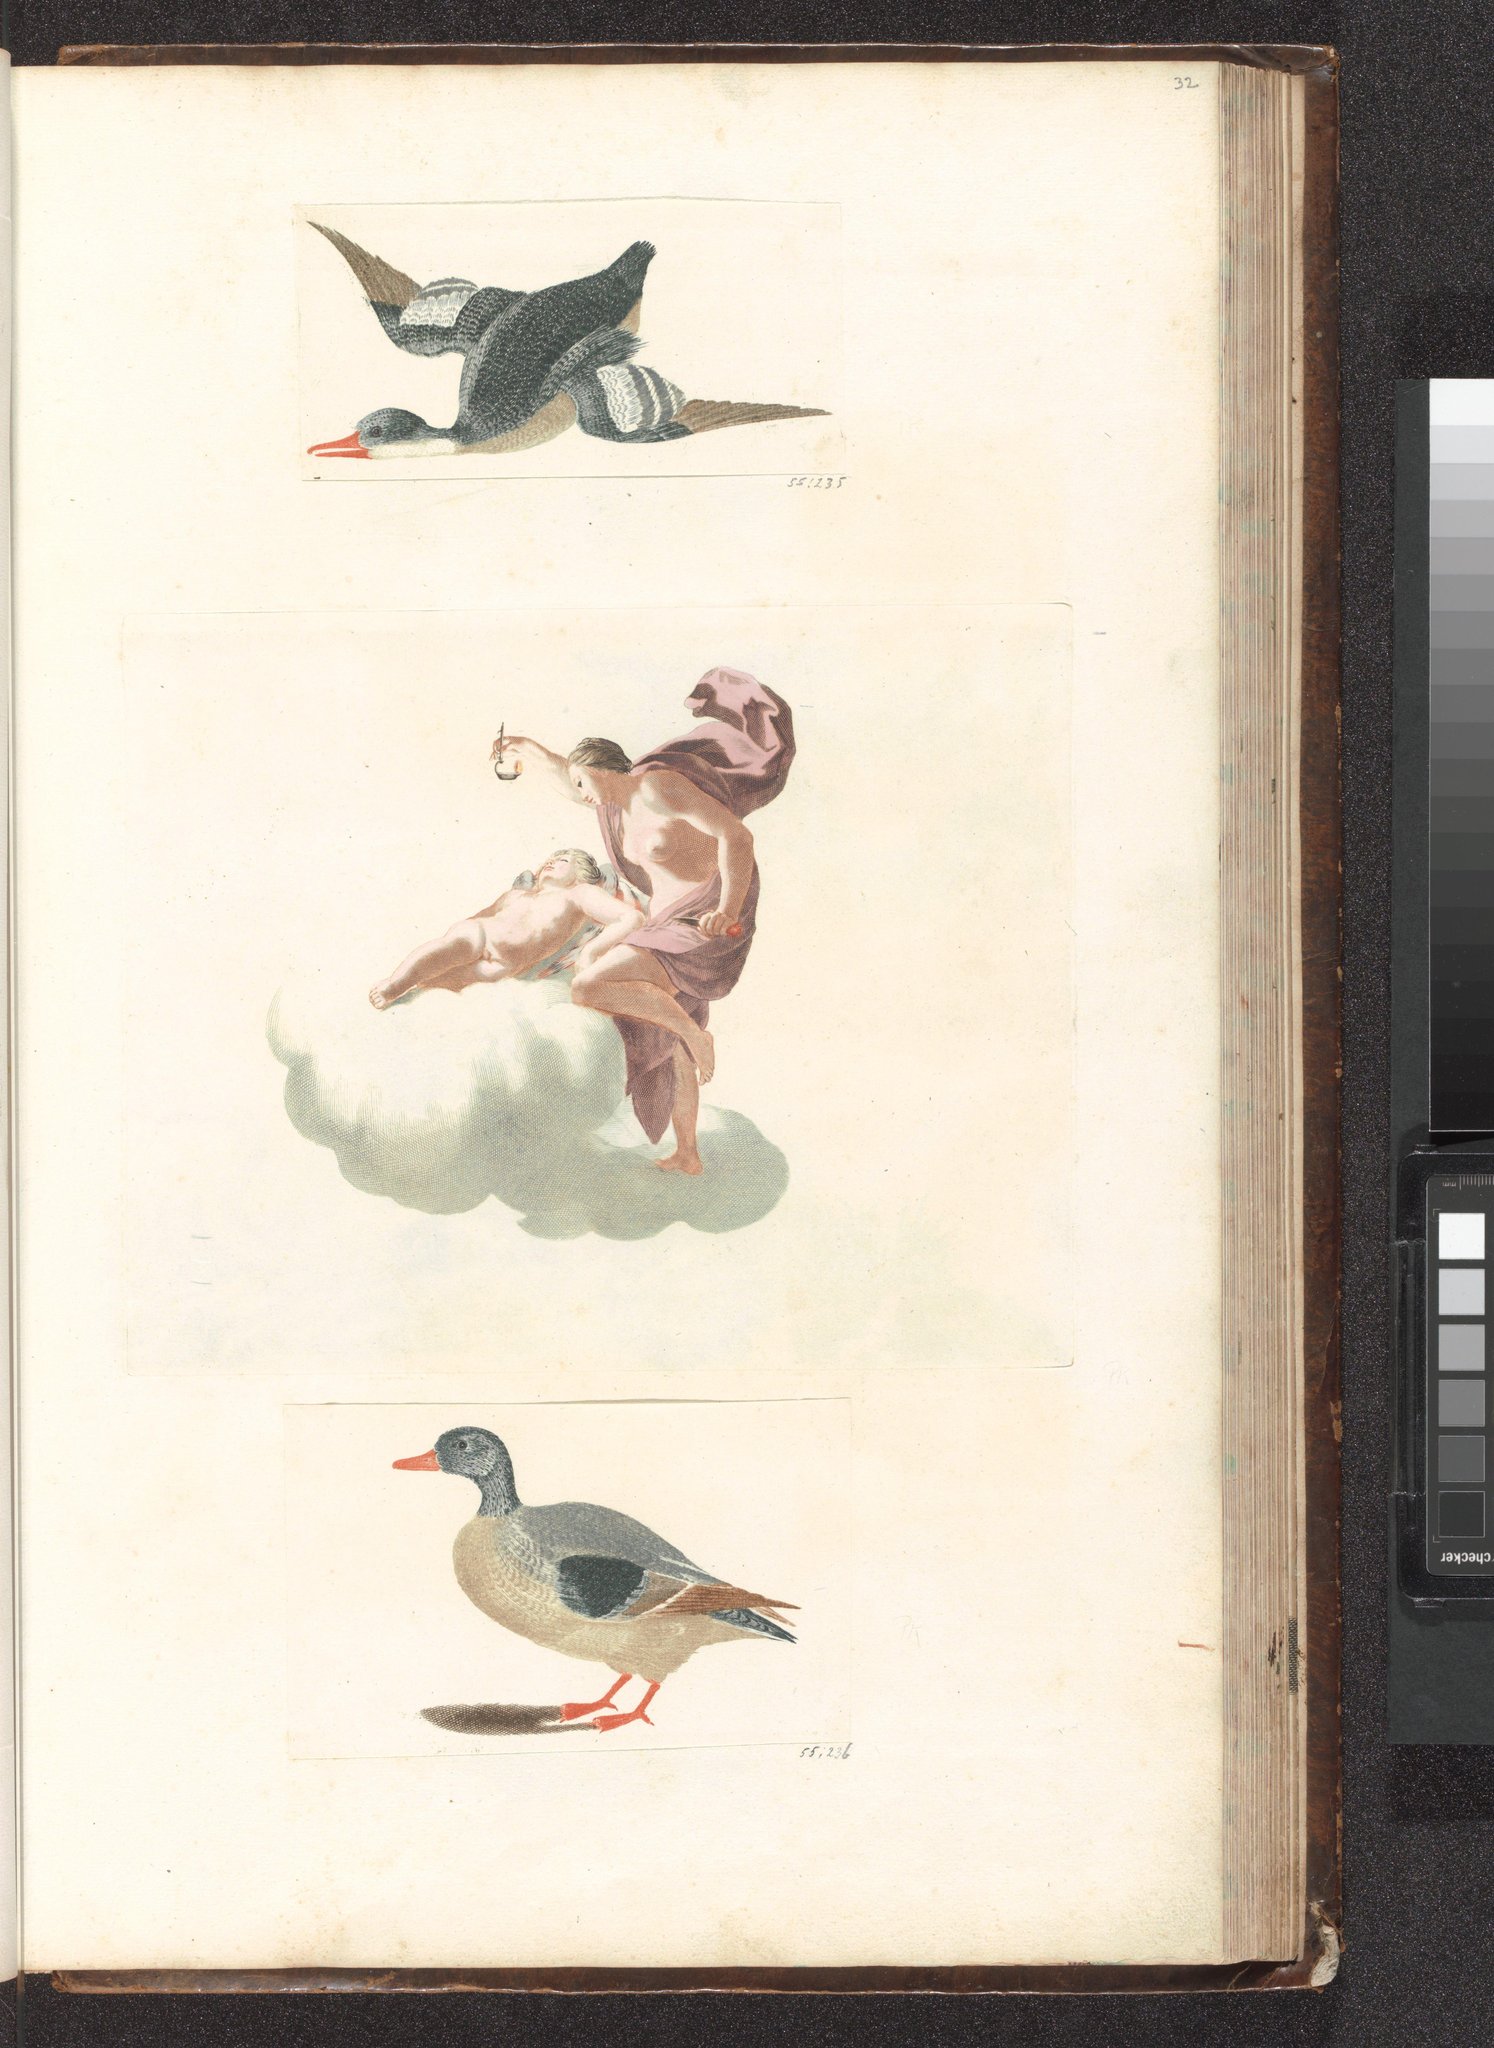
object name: print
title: Naar links vliegende eend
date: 1688-1698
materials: paper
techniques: printing, engraving, lithography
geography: netherlands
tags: water-birds: duck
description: Naar links vliegende eend, mogelijk een grote zaagbek. Deze prent maakt deel uit van een album.